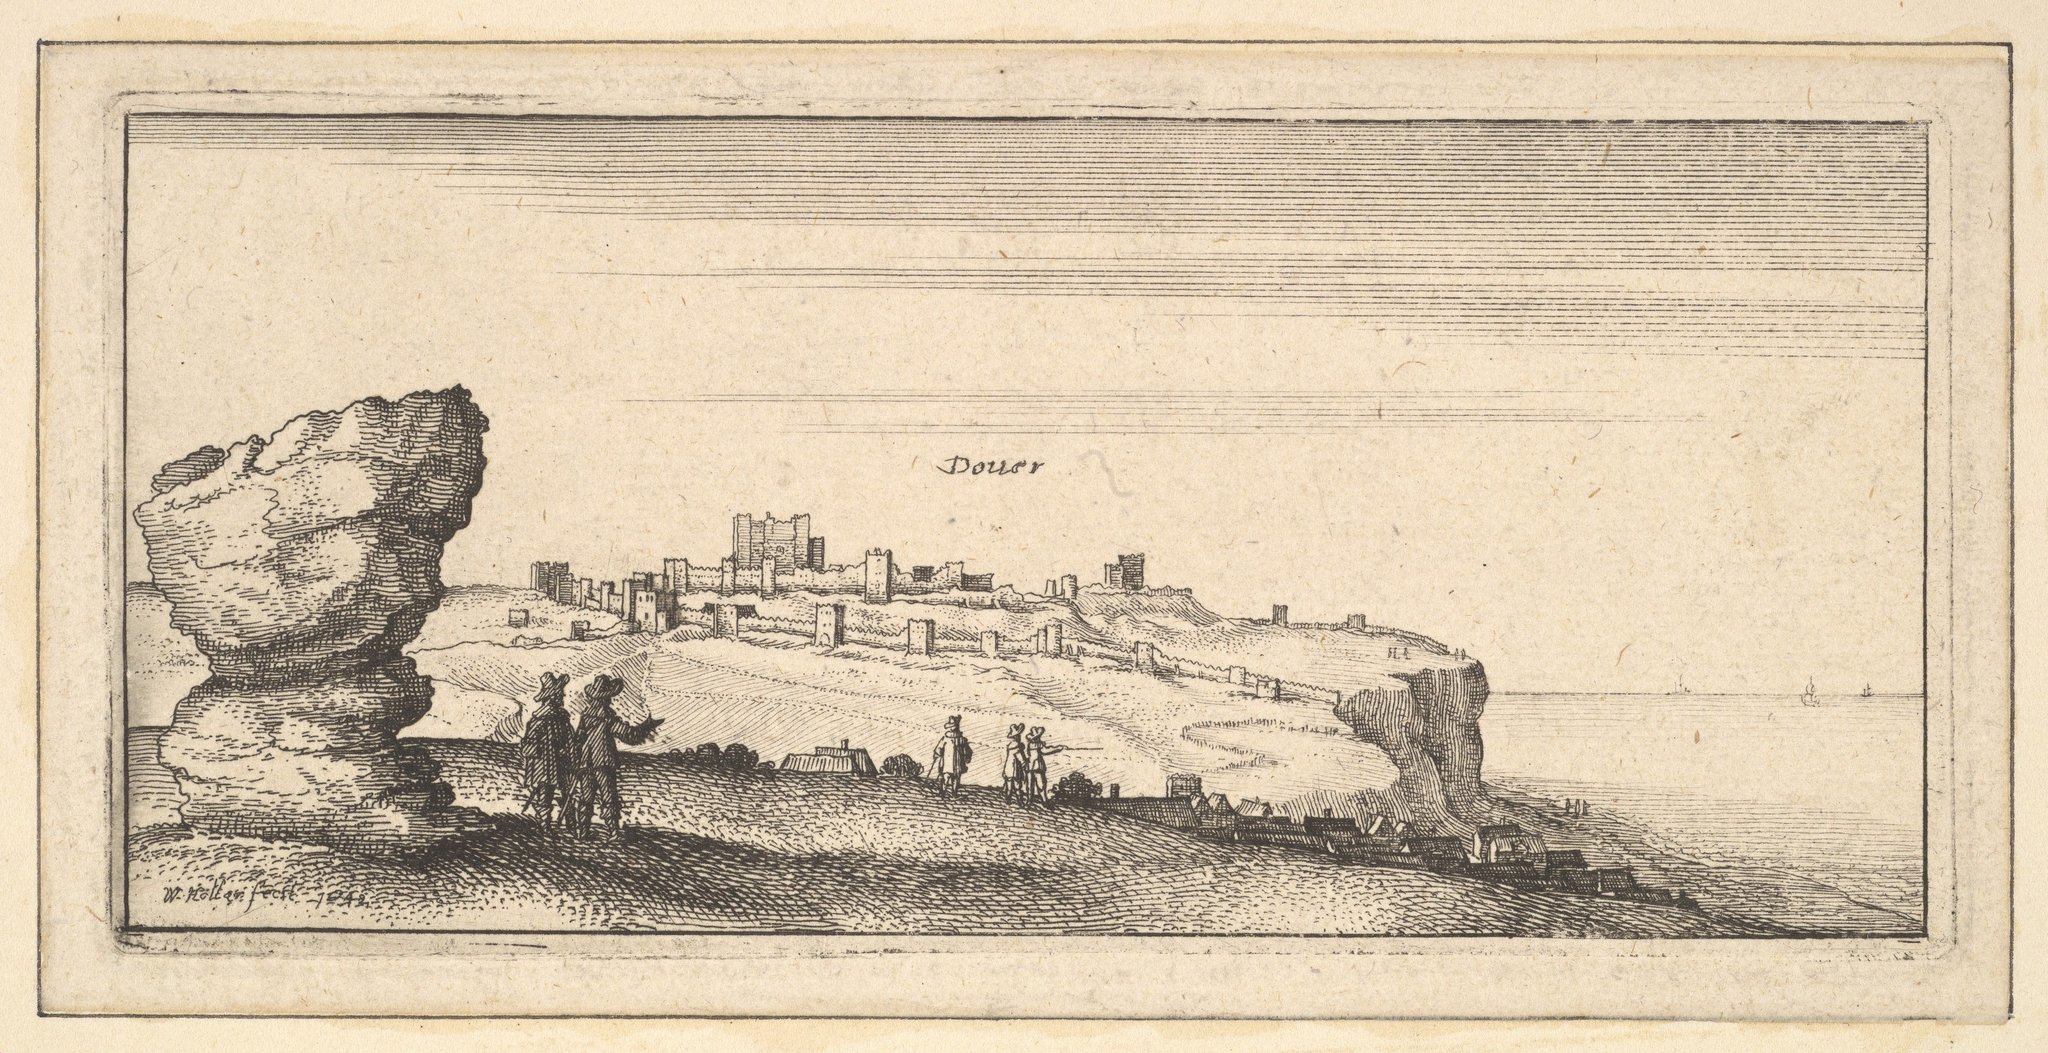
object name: print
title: Douer (Dover)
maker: wenceslaus hollar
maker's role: artist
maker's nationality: bohemian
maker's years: 1607-1677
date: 1642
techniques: etching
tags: castles